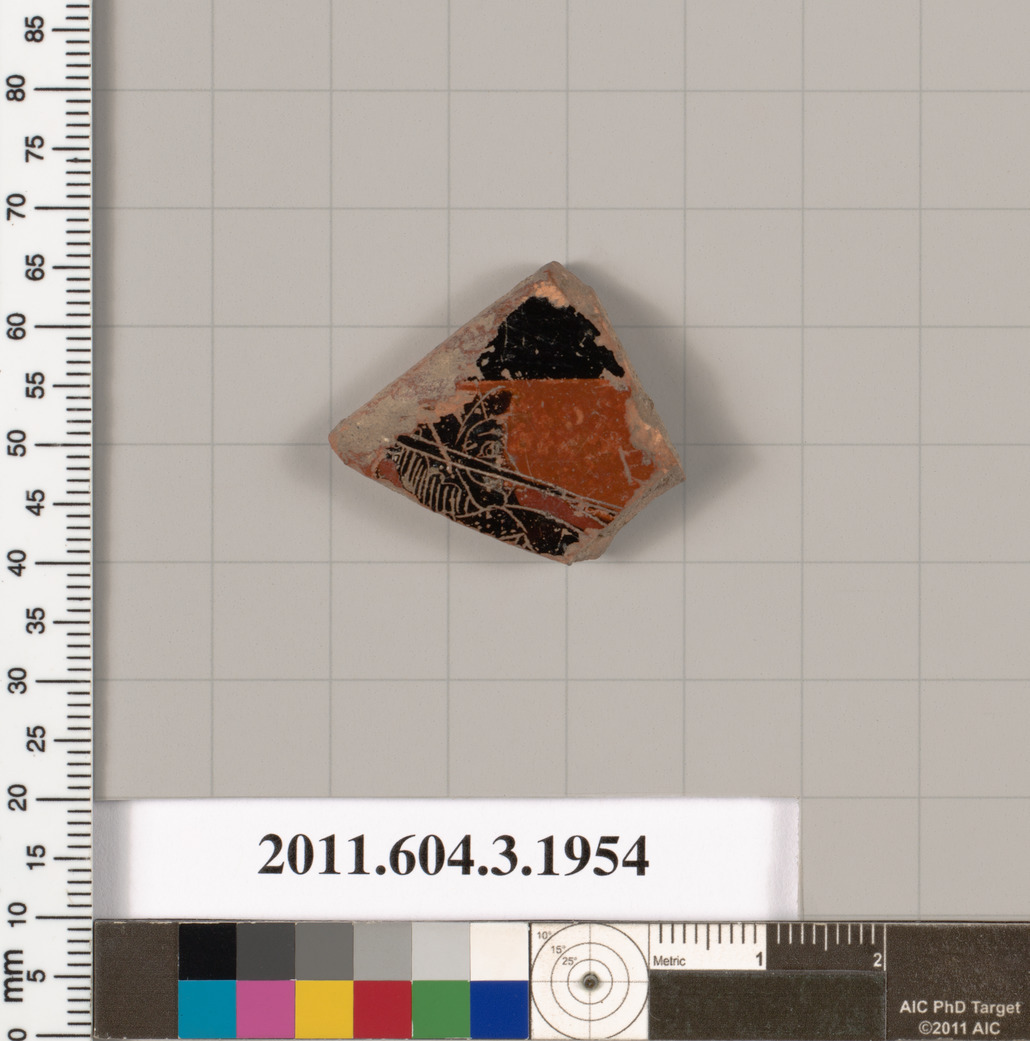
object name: kylix fragment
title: Terracotta fragment of a kylix (drinking cup)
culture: greek, attic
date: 550-526 BCE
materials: terracotta